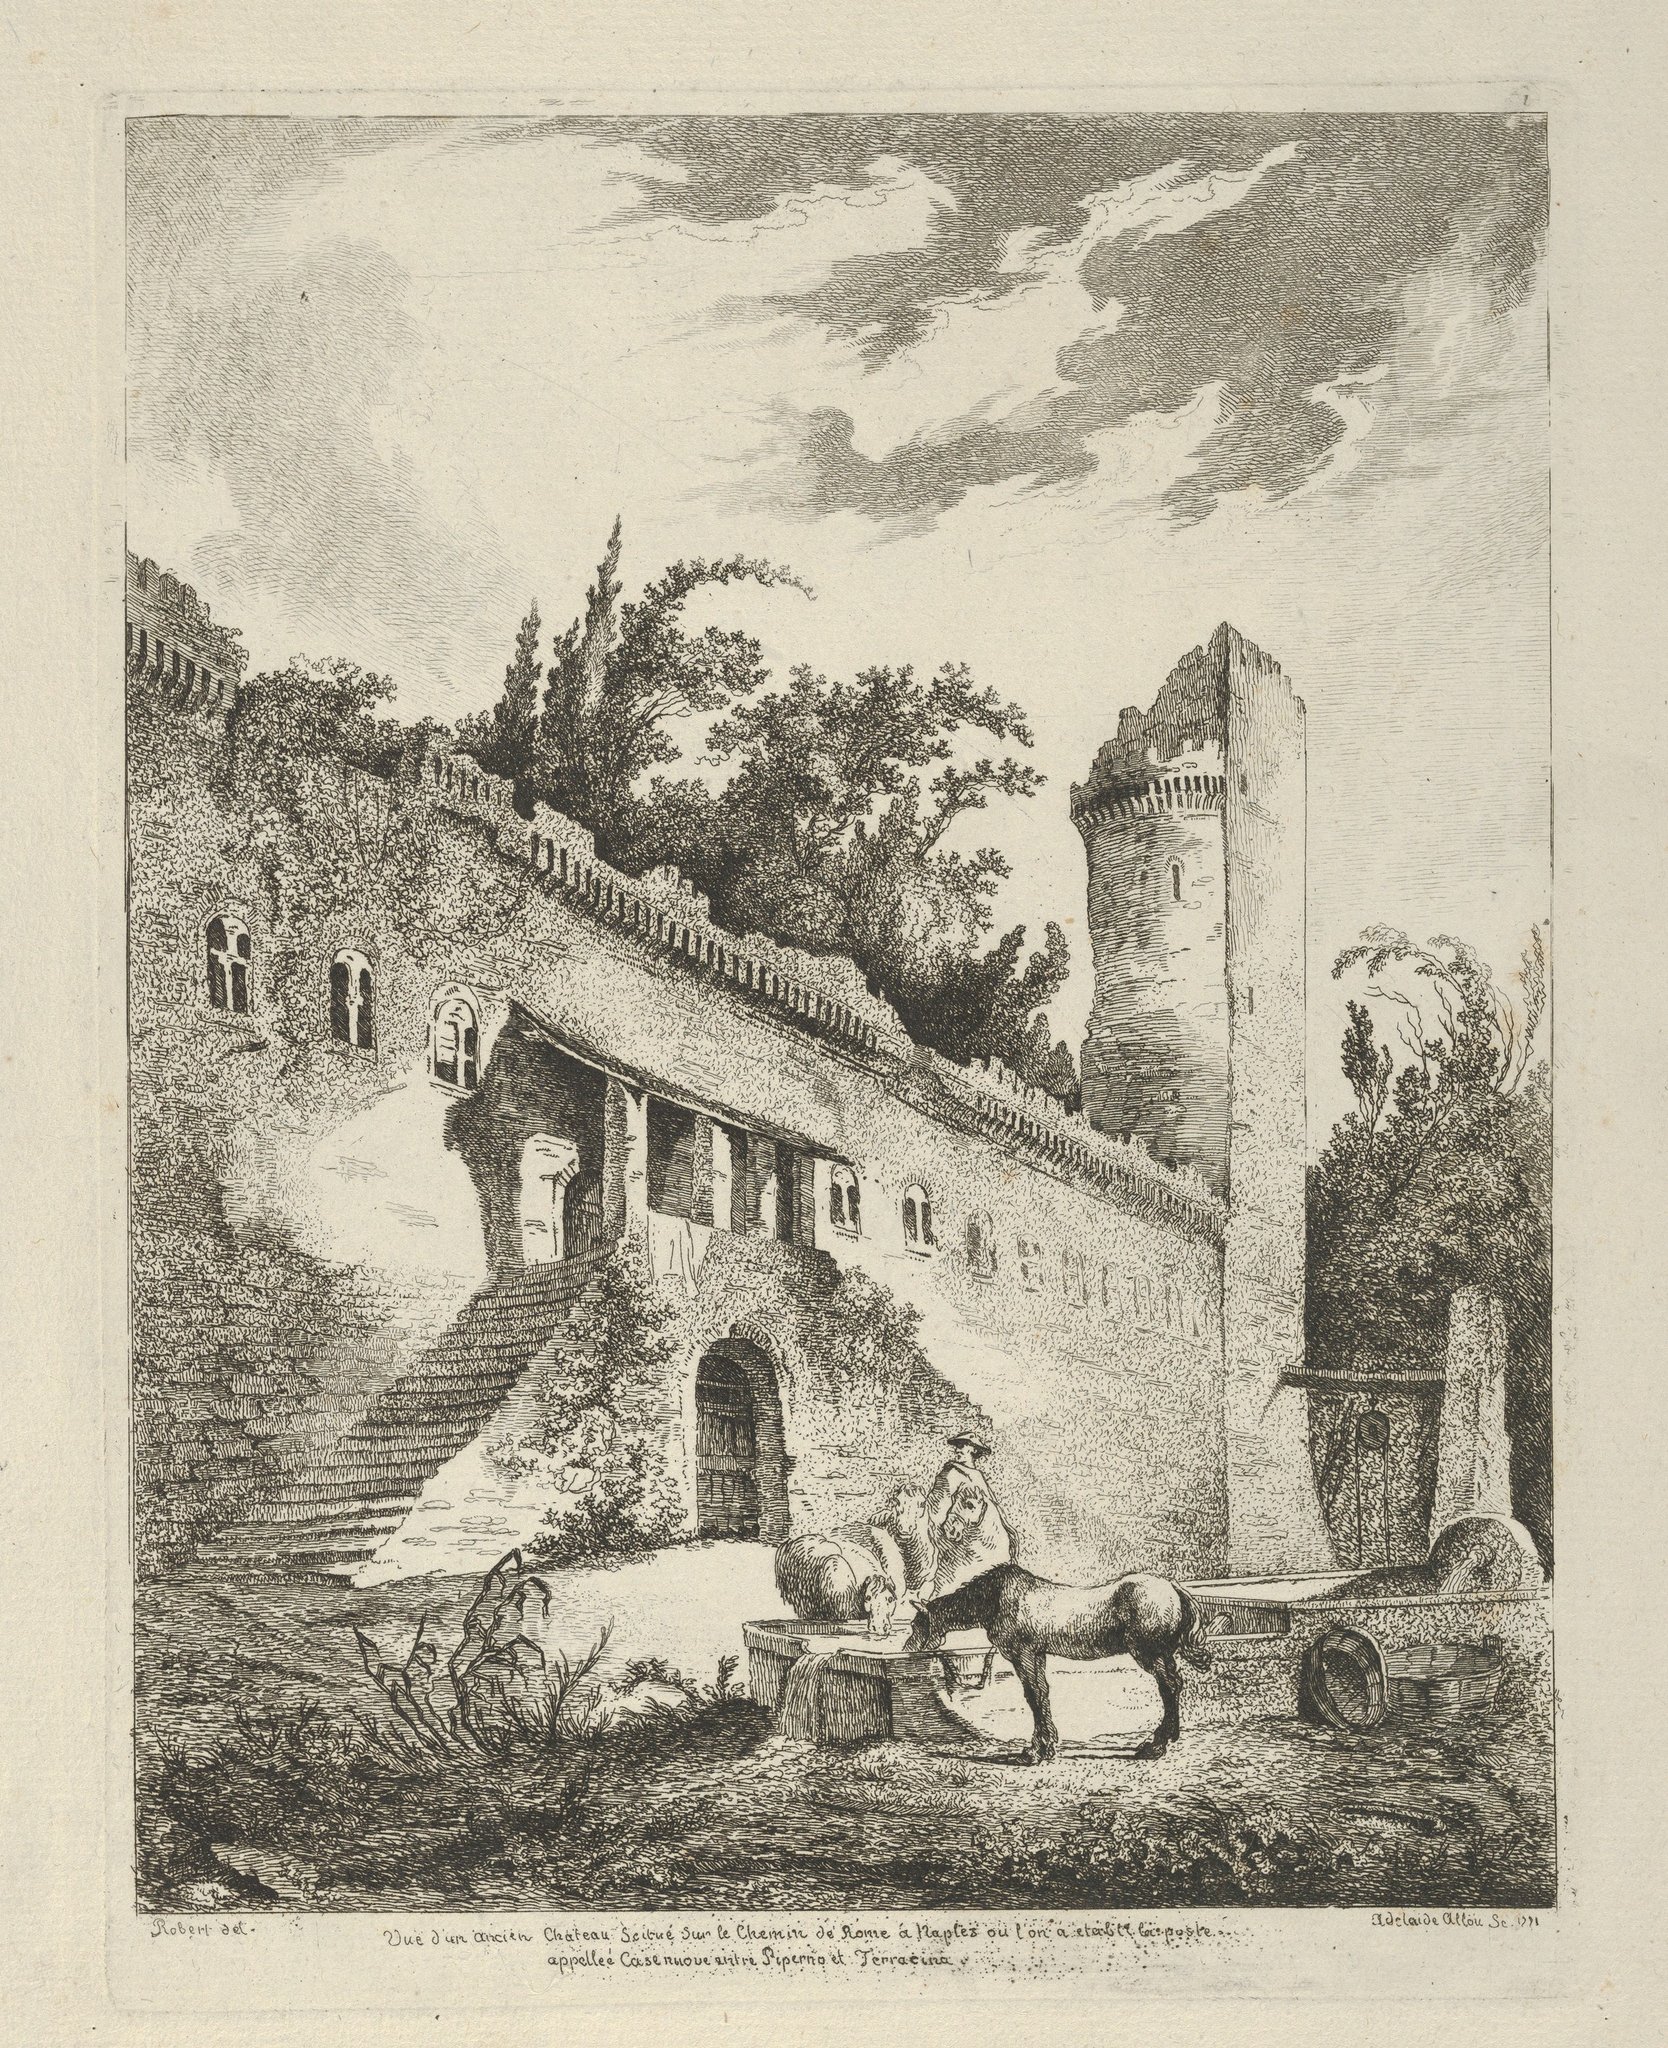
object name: print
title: Vue d'un ancien chateau scitué sur le chemin de Rome à Naples from Differentes vues dessiné d'après nature... dans les environs de Rome et de Naples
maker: adélaide allou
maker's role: artist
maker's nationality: french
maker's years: 1776-1800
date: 1701-1800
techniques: etching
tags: ruins,horses